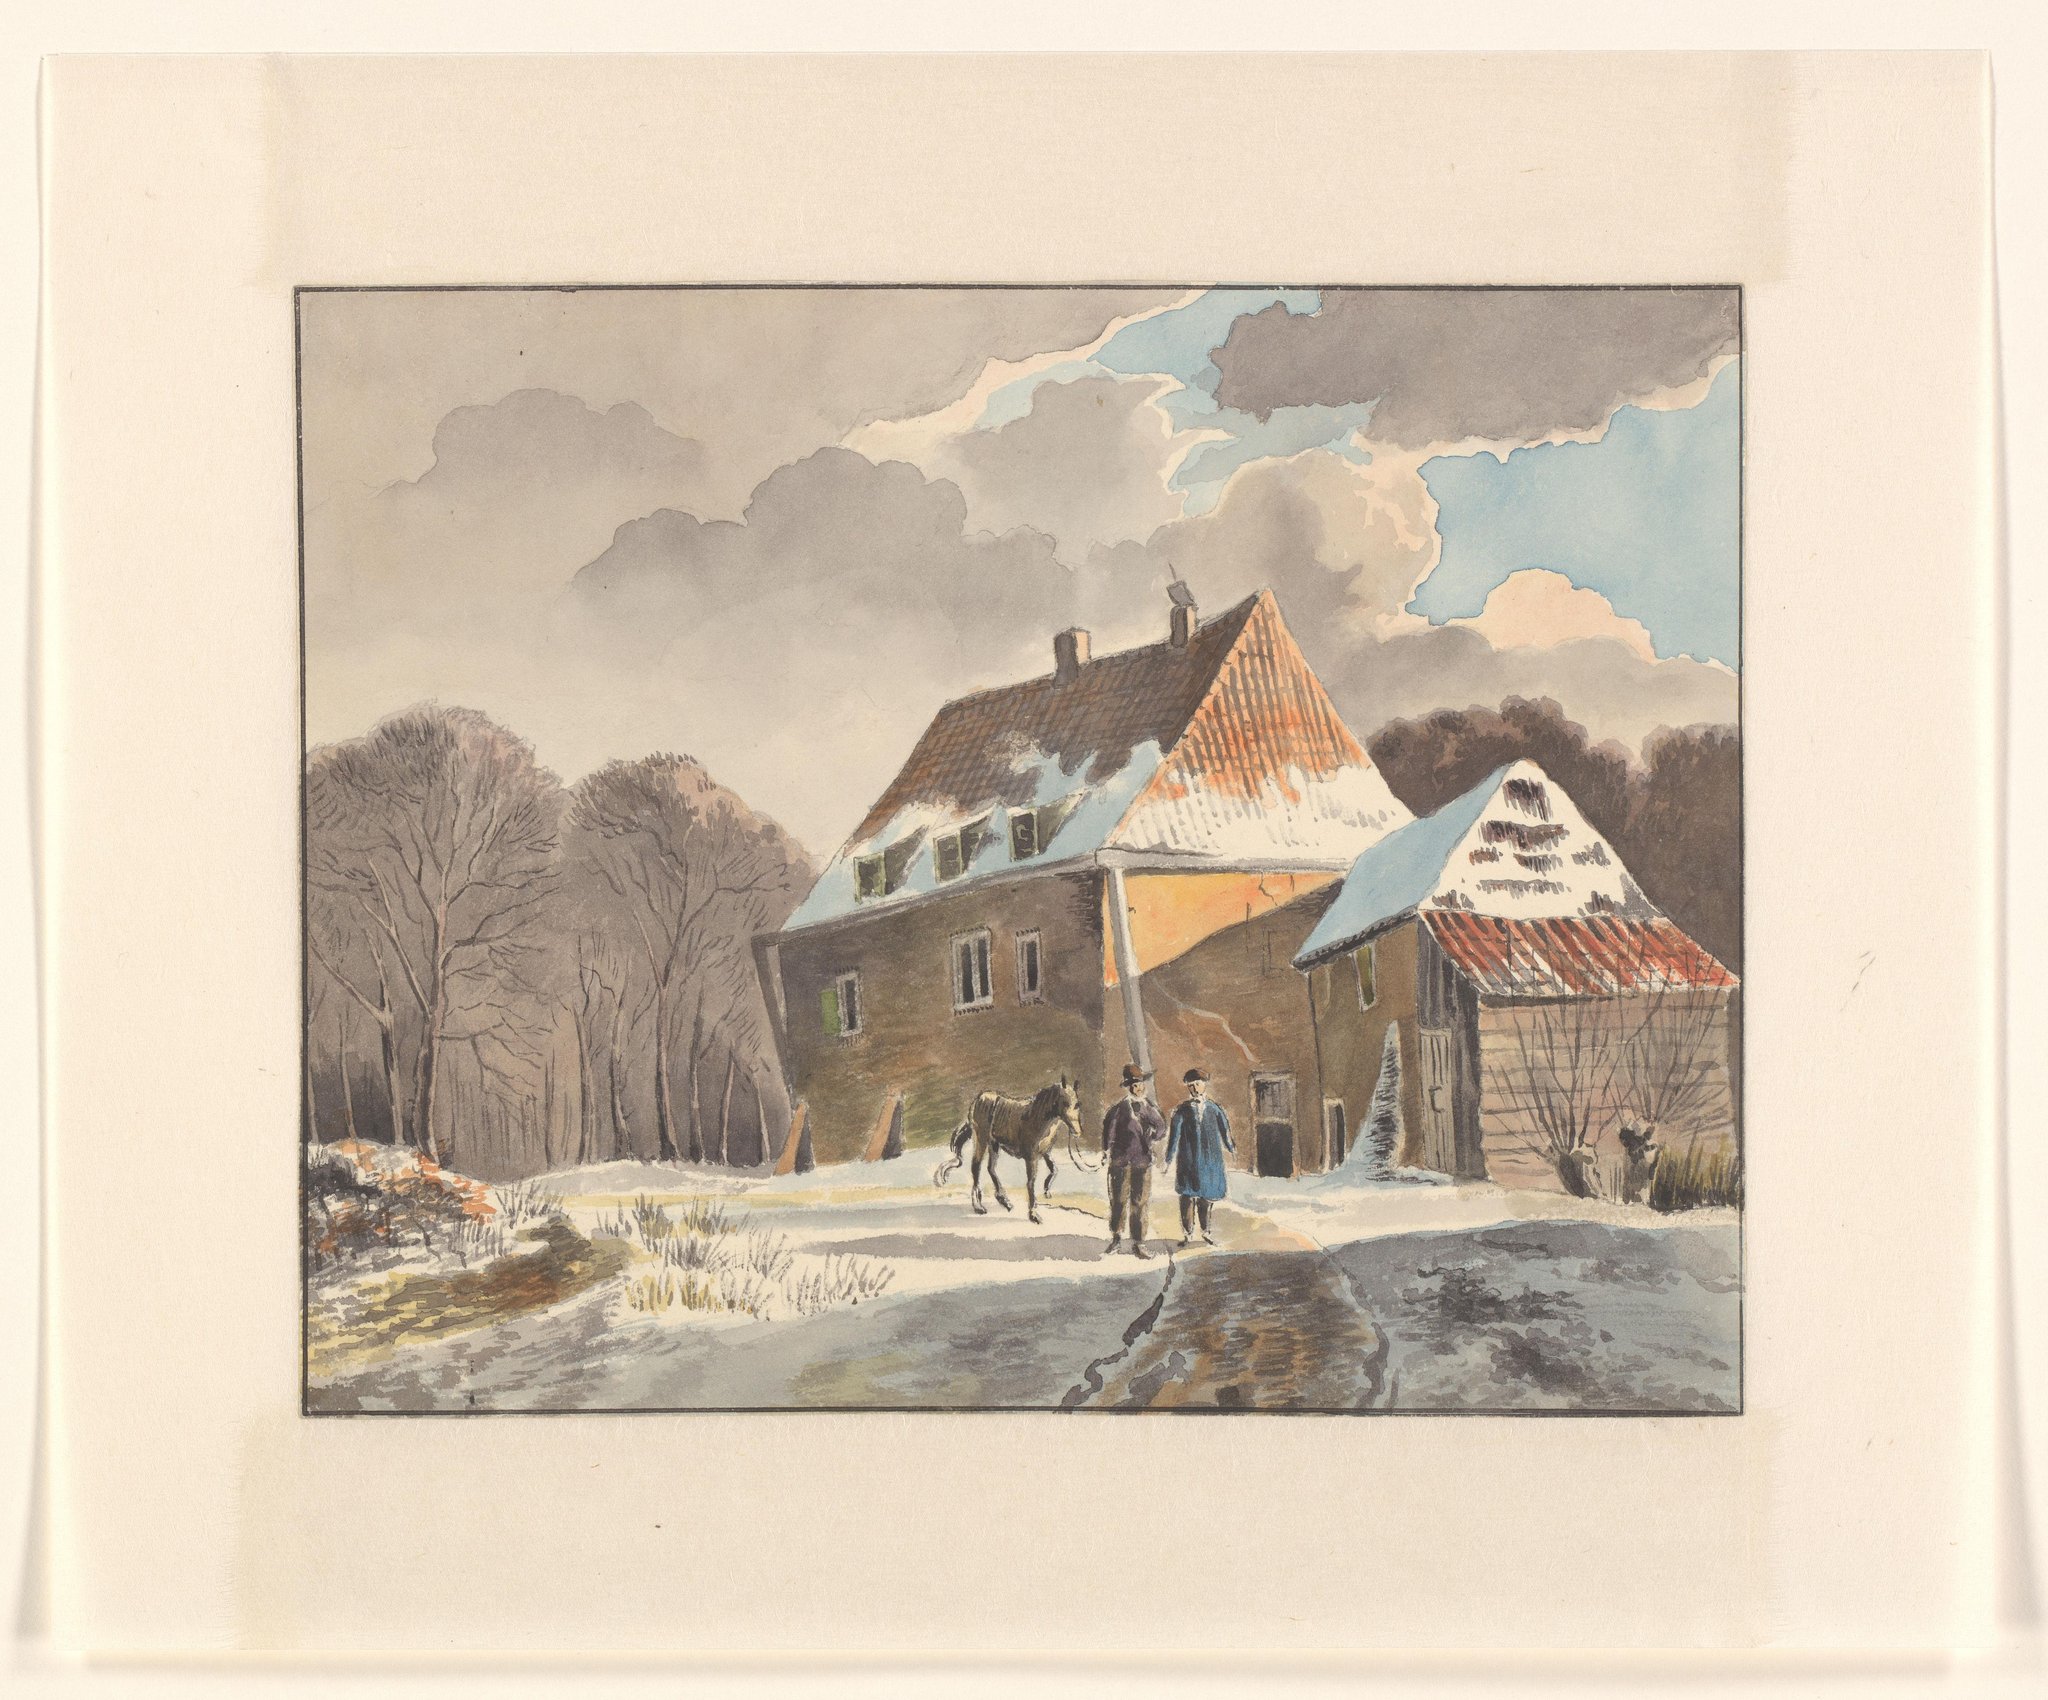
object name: drawing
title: Winterlandschap met boerderij en figuren op een pad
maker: johannes van reijn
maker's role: draughtsman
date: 1800-1900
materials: paper, pencil, watercolor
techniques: brush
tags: winter, 'hyems'; 'inverno' (ripa), farm or solitary house in landscape